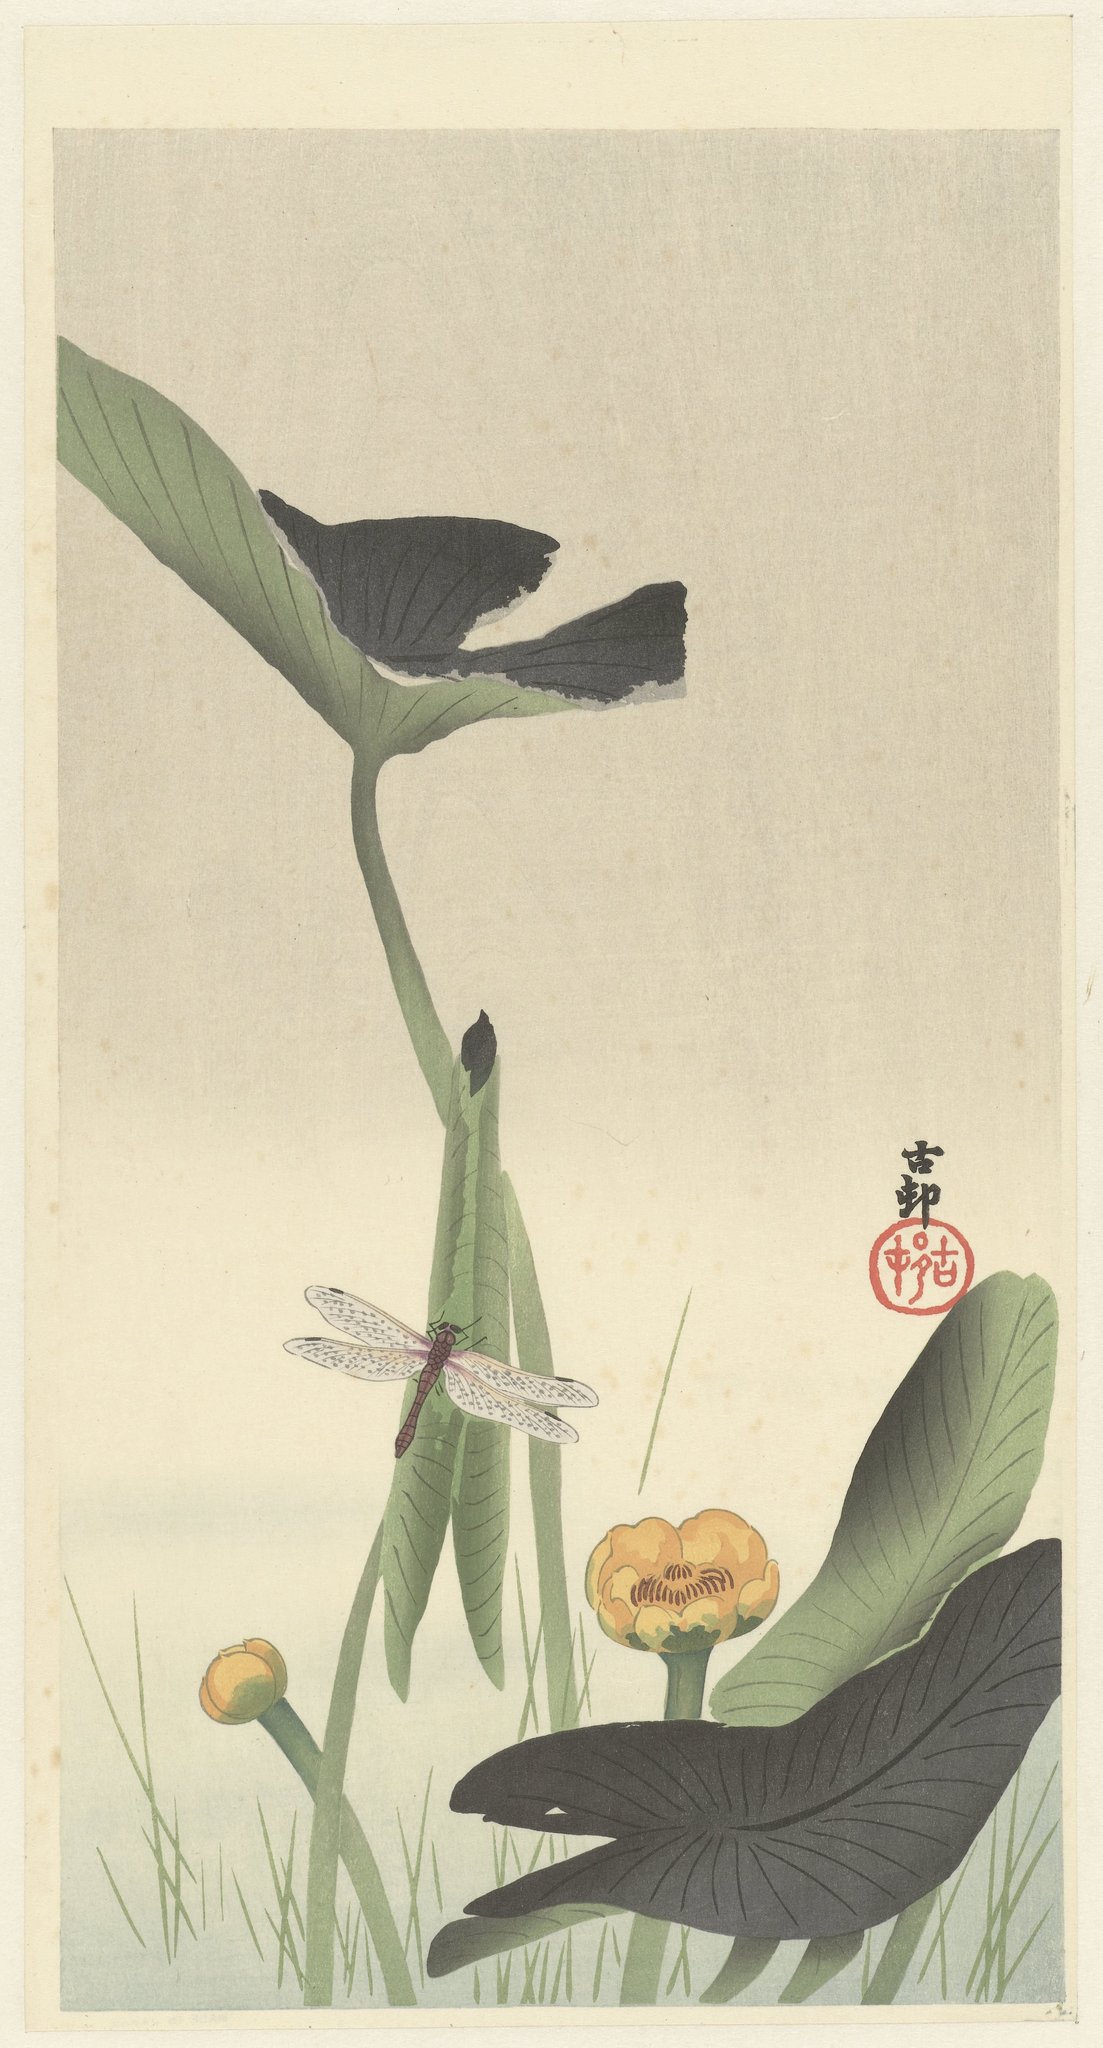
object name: print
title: Libelle en lotus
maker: ohara koson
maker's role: print maker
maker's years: 1877-1945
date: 1900-1930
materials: paper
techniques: woodcut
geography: japan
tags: flowers, insects: dragon-fly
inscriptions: collector's mark: Lugt 2228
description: Lotus met gele bloemen; libelle op een dichtgevouwen blad.